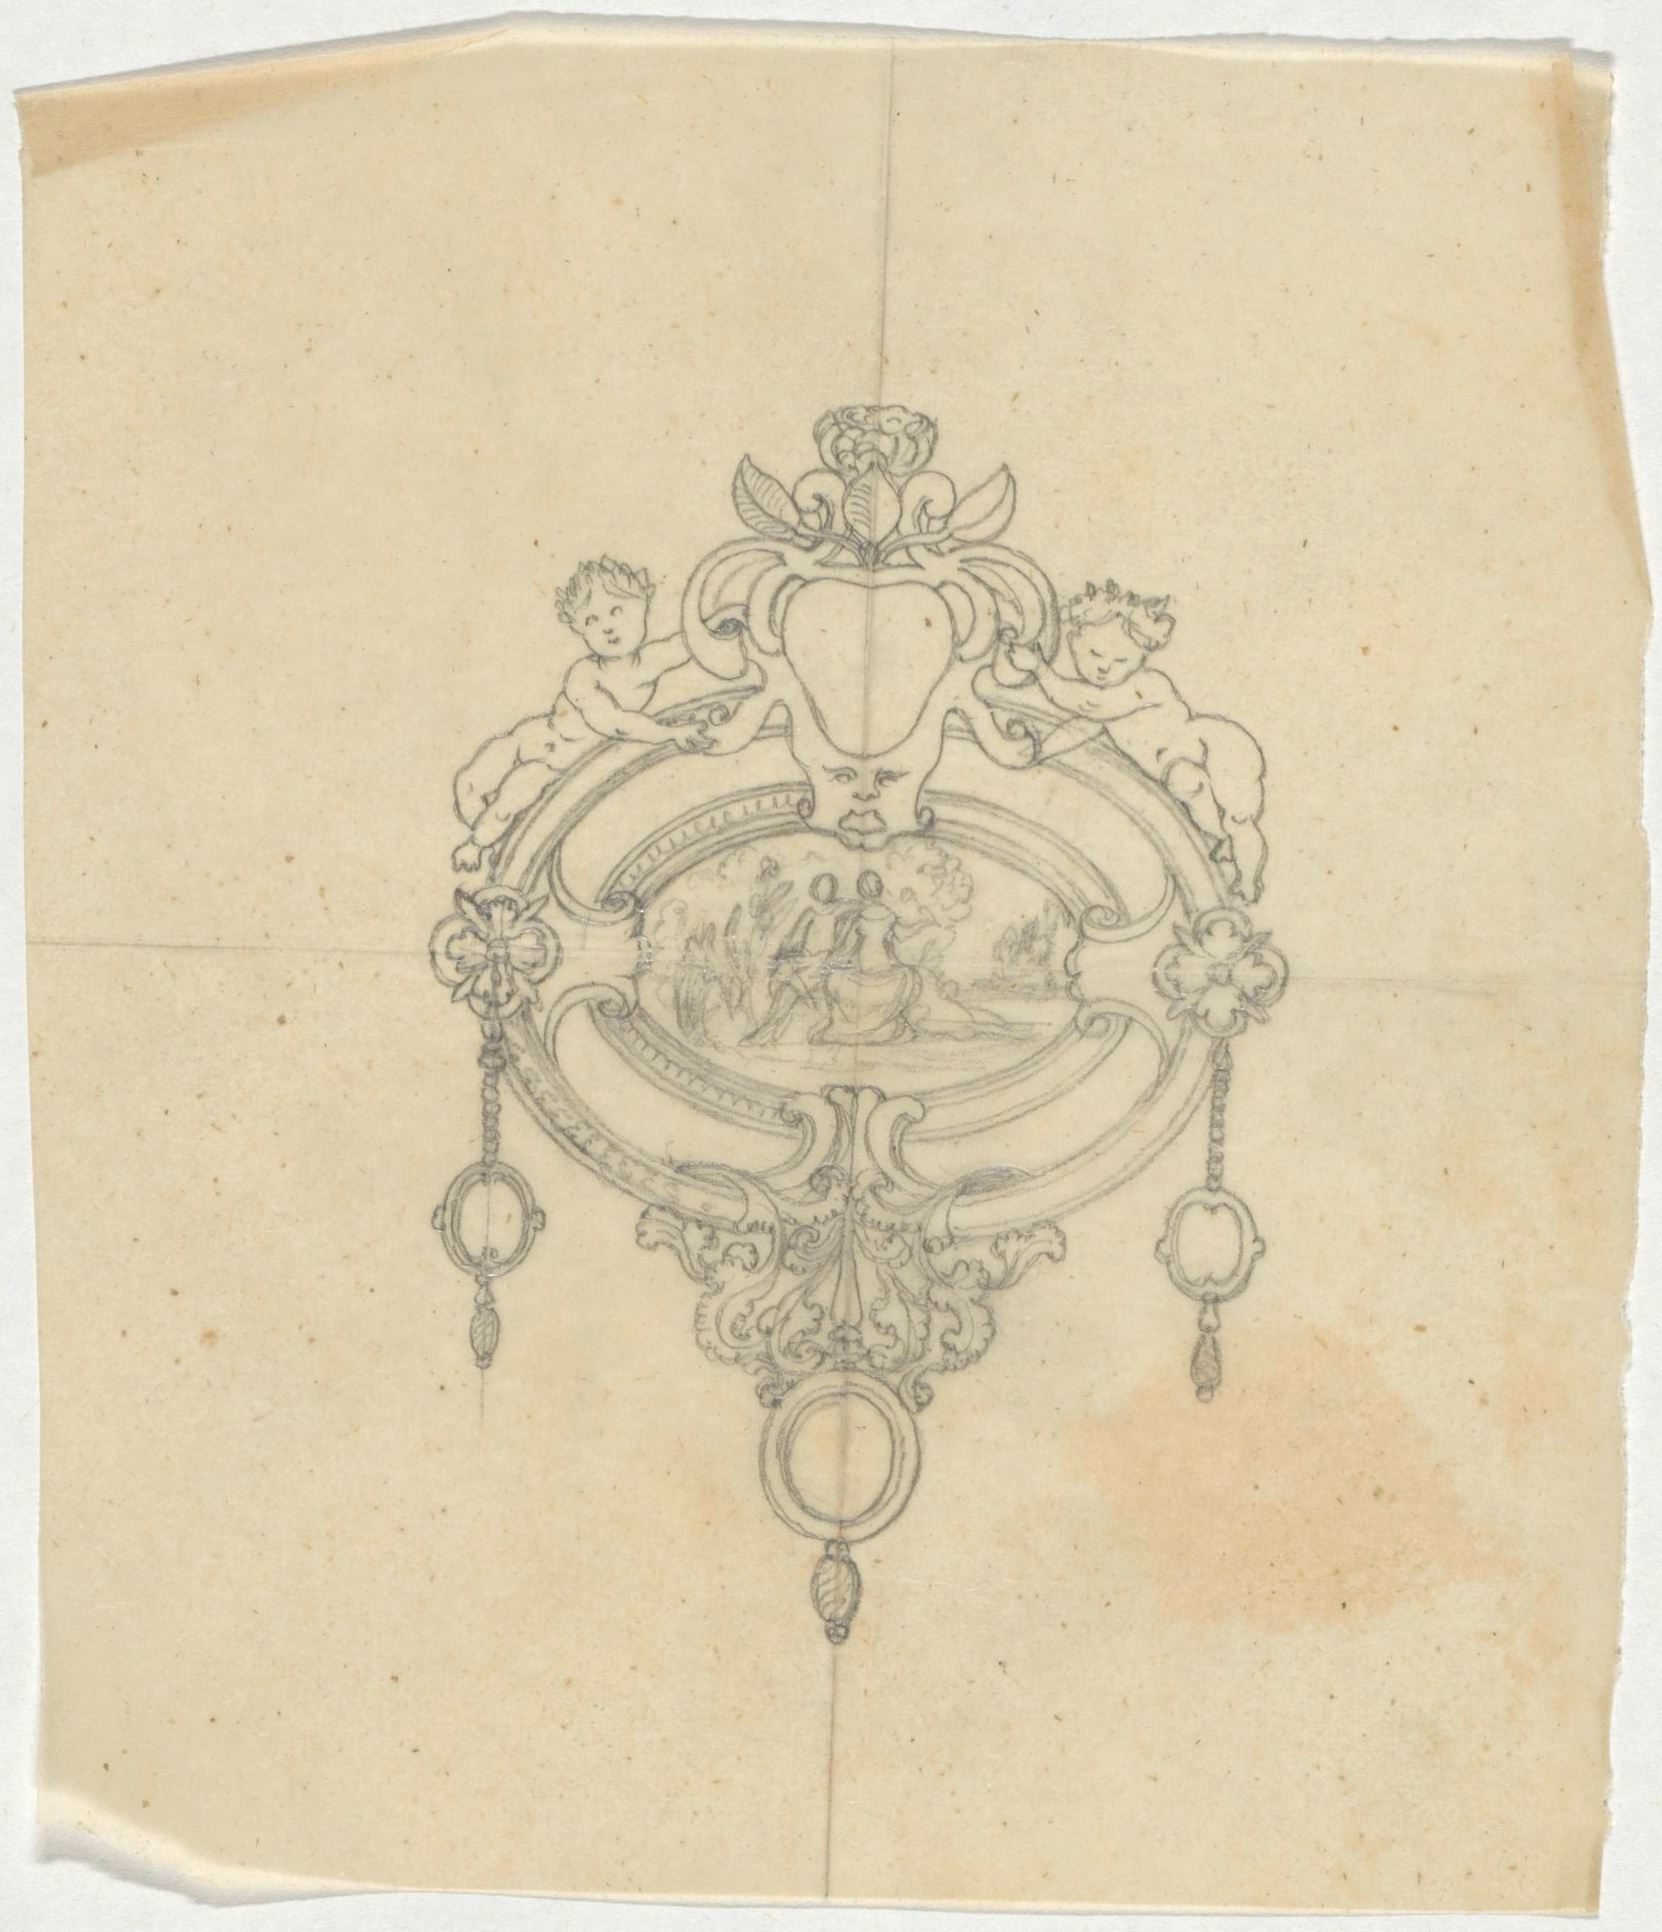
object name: design drawing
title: Medaillon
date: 1830-1850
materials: graphite, paper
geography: paris